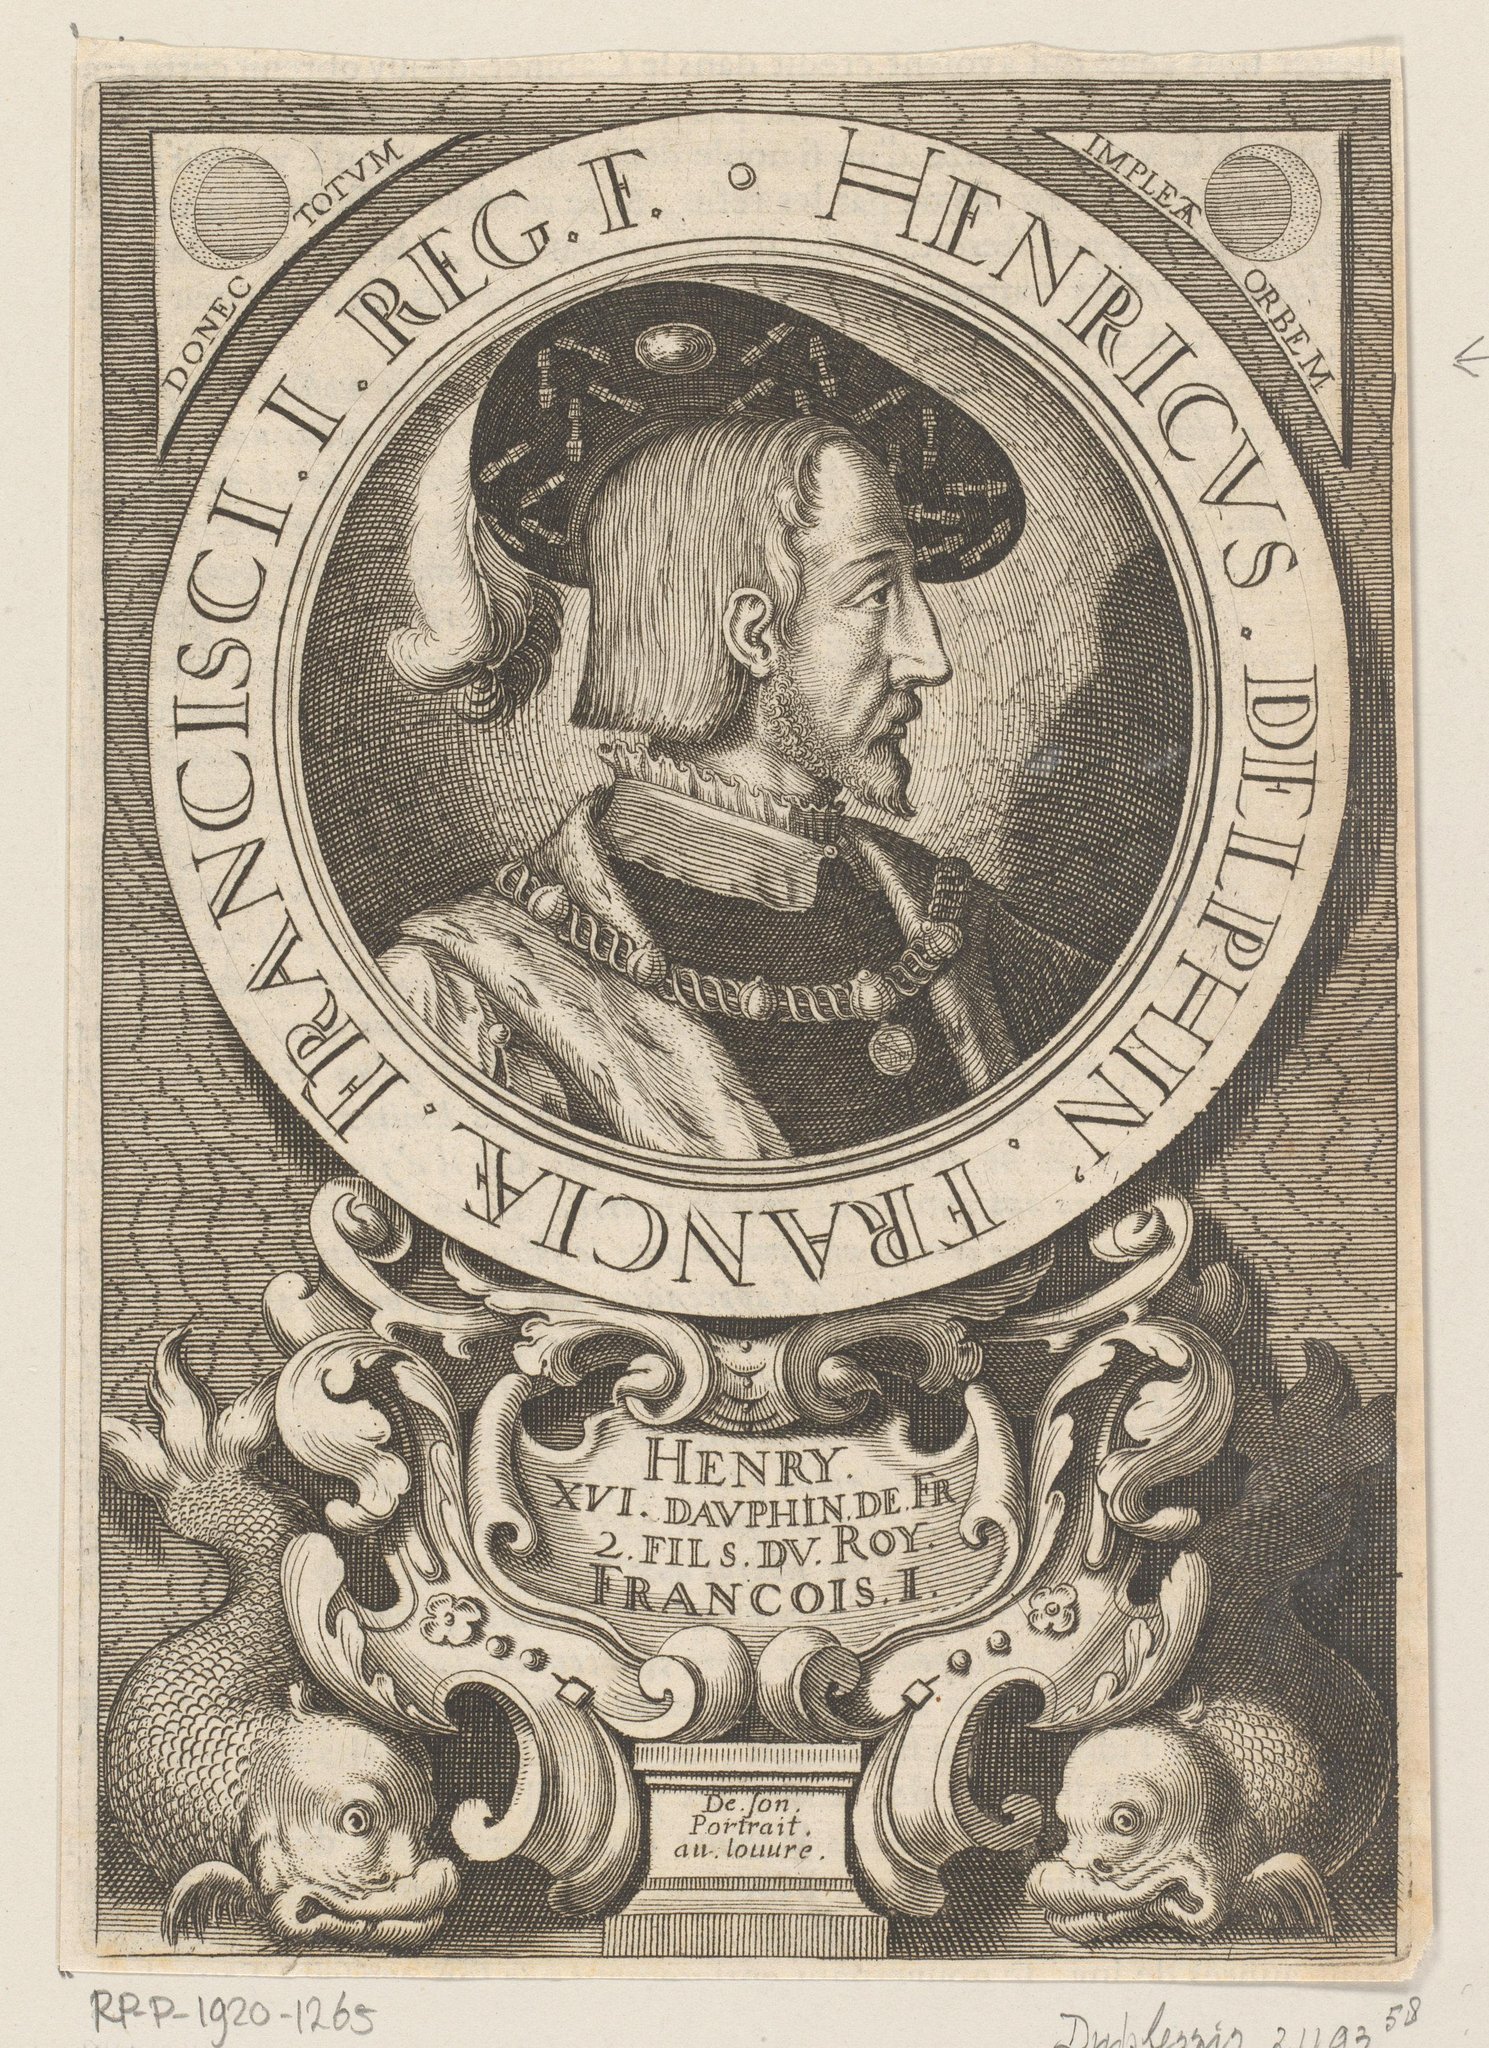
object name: book illustration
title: Henry XVI dauphin de Fr 2 fils du roy Francois I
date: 1635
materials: paper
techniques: engraving, letterpress printing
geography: paris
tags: paris, historical persons, ruler, sovereign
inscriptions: collector's mark: Lugt 2228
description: Prent uit: Eudes de Mézeray, François. Histoire de France, depuis Faramond jusqu’au regne de Louis le Juste (...). 3 dln. Parijs: Denis Thierry, Jean Guignard en Claude Barbin, 1635, dl. 1. Prent waarschijnlijk voor het eerst verschenen in: Bie, Jacques de. Les vrais portraits des rois de France (...). Parijs: Jacques de Bie en Pierre Rocolet, 1634. Prent ook gebruikt in latere publicaties.